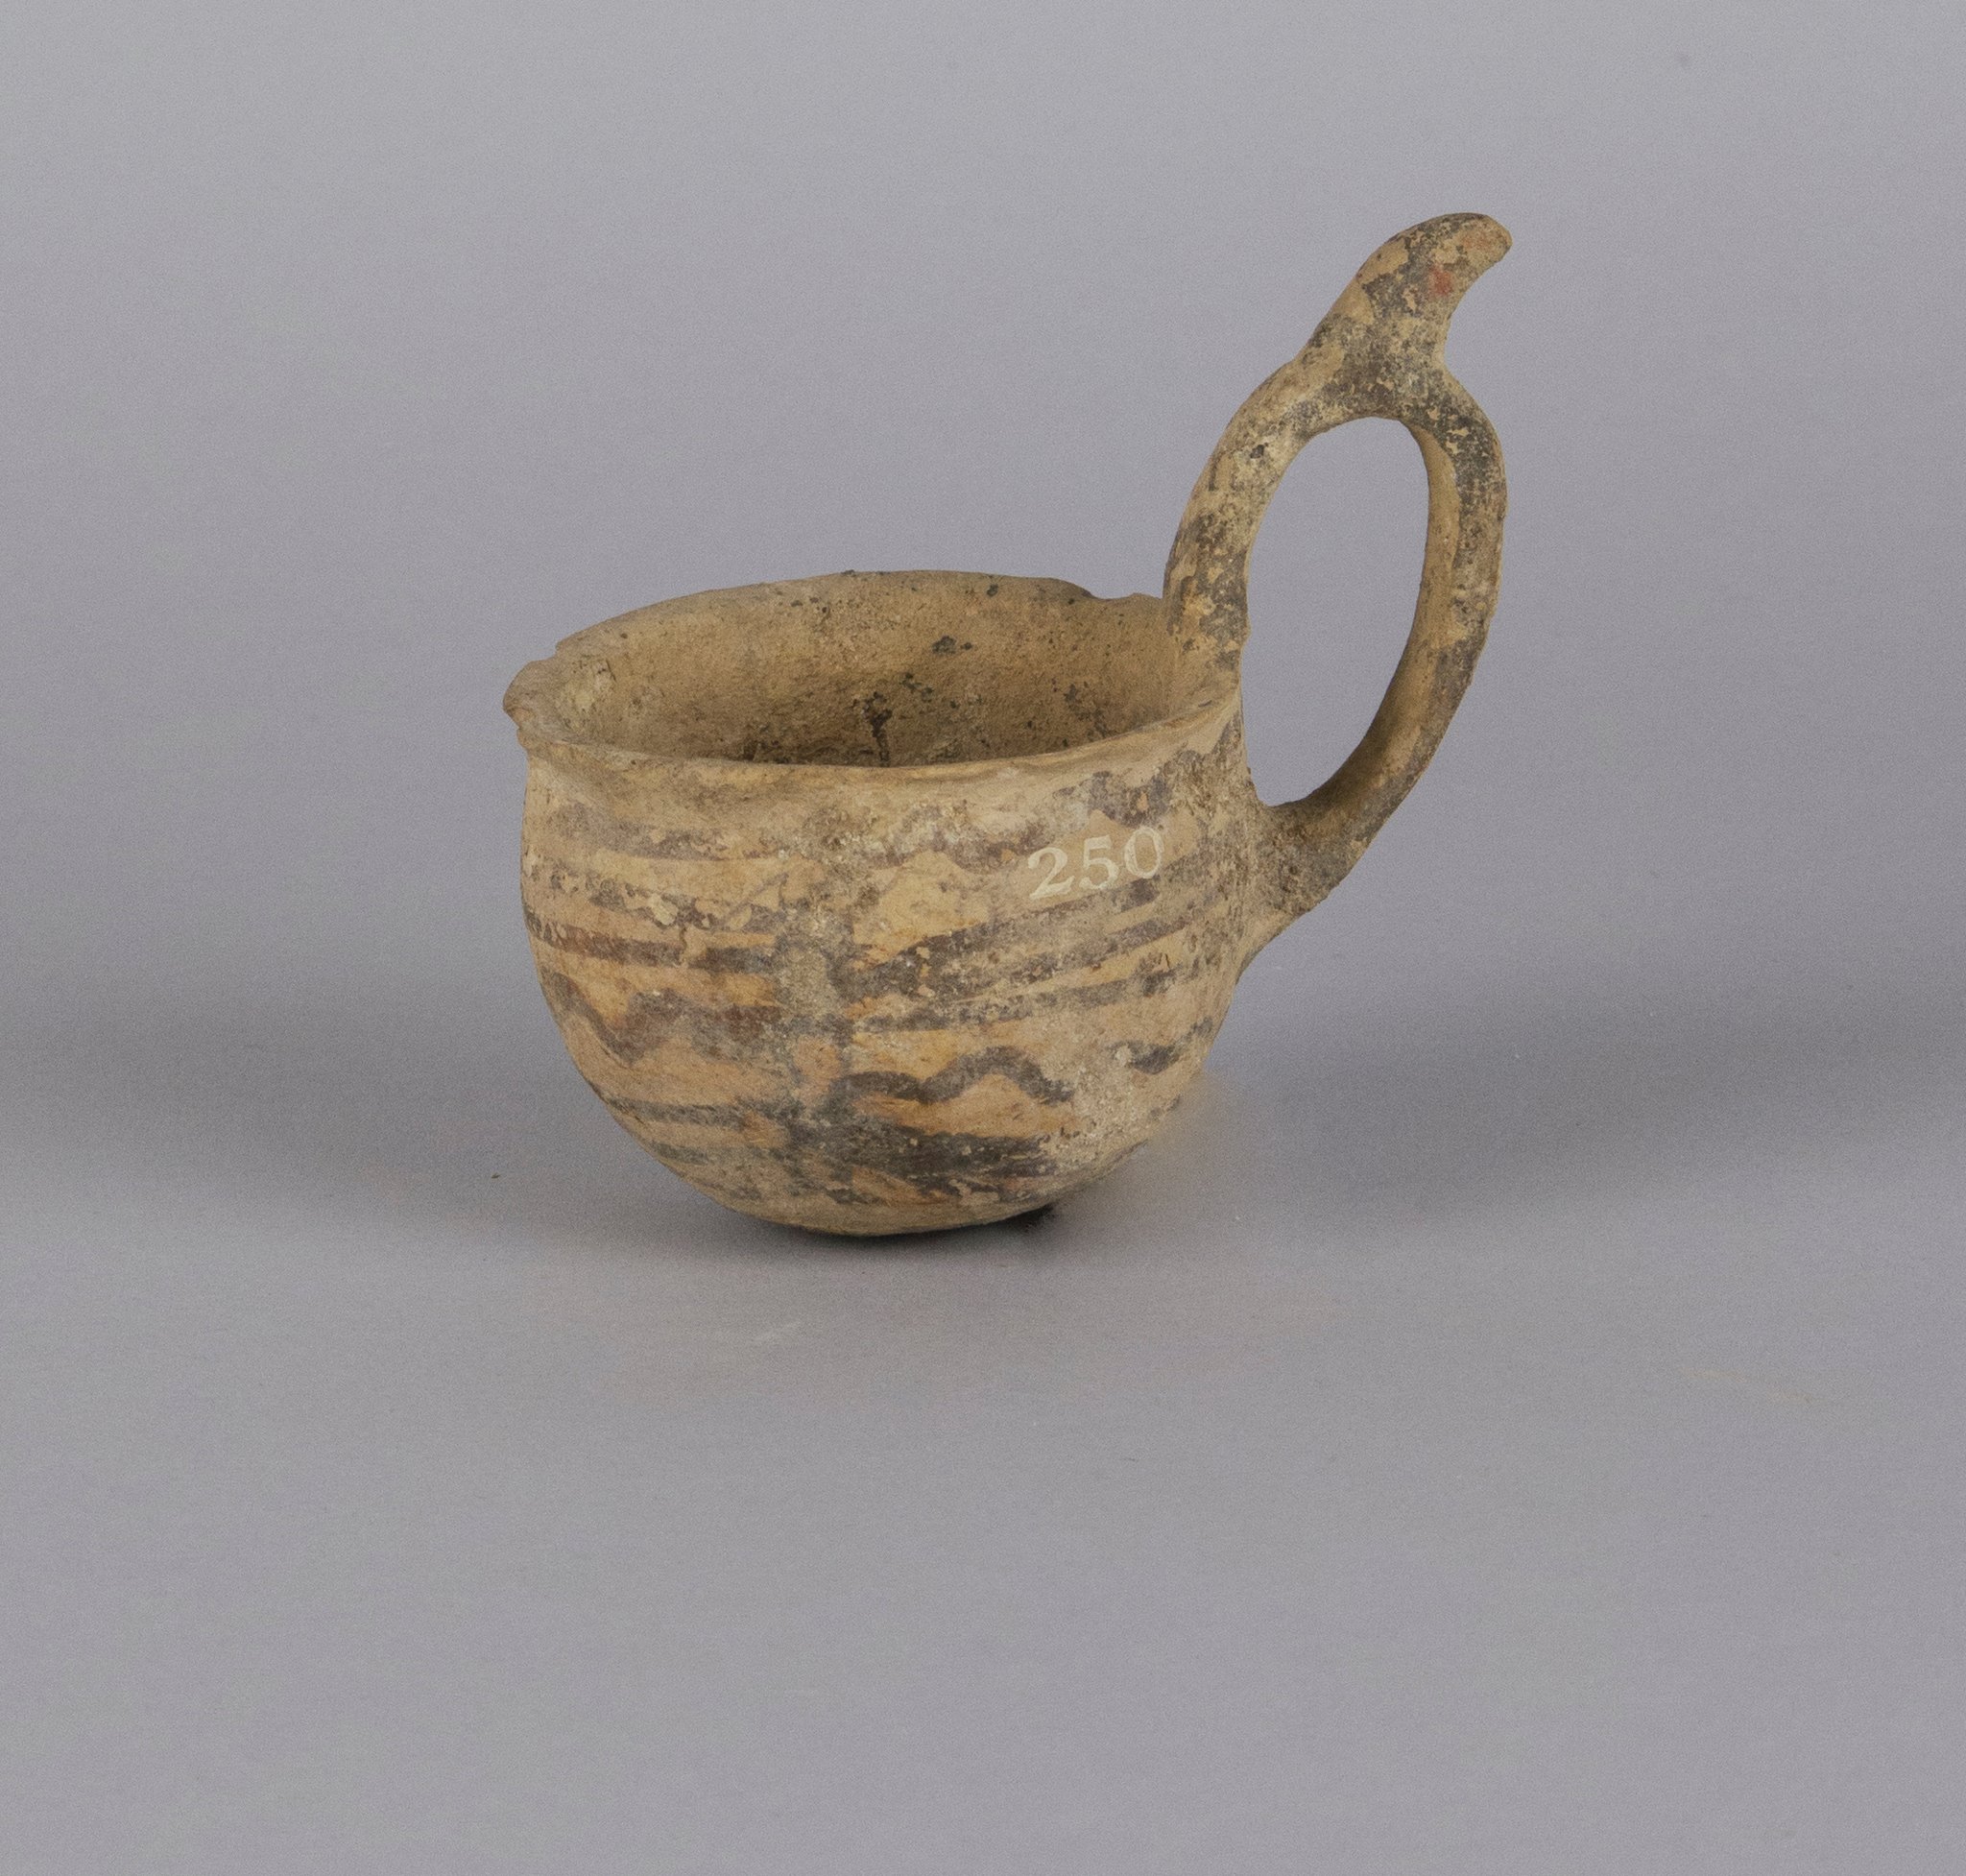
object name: cup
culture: cypriot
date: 3200-1050 BCE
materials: terracotta